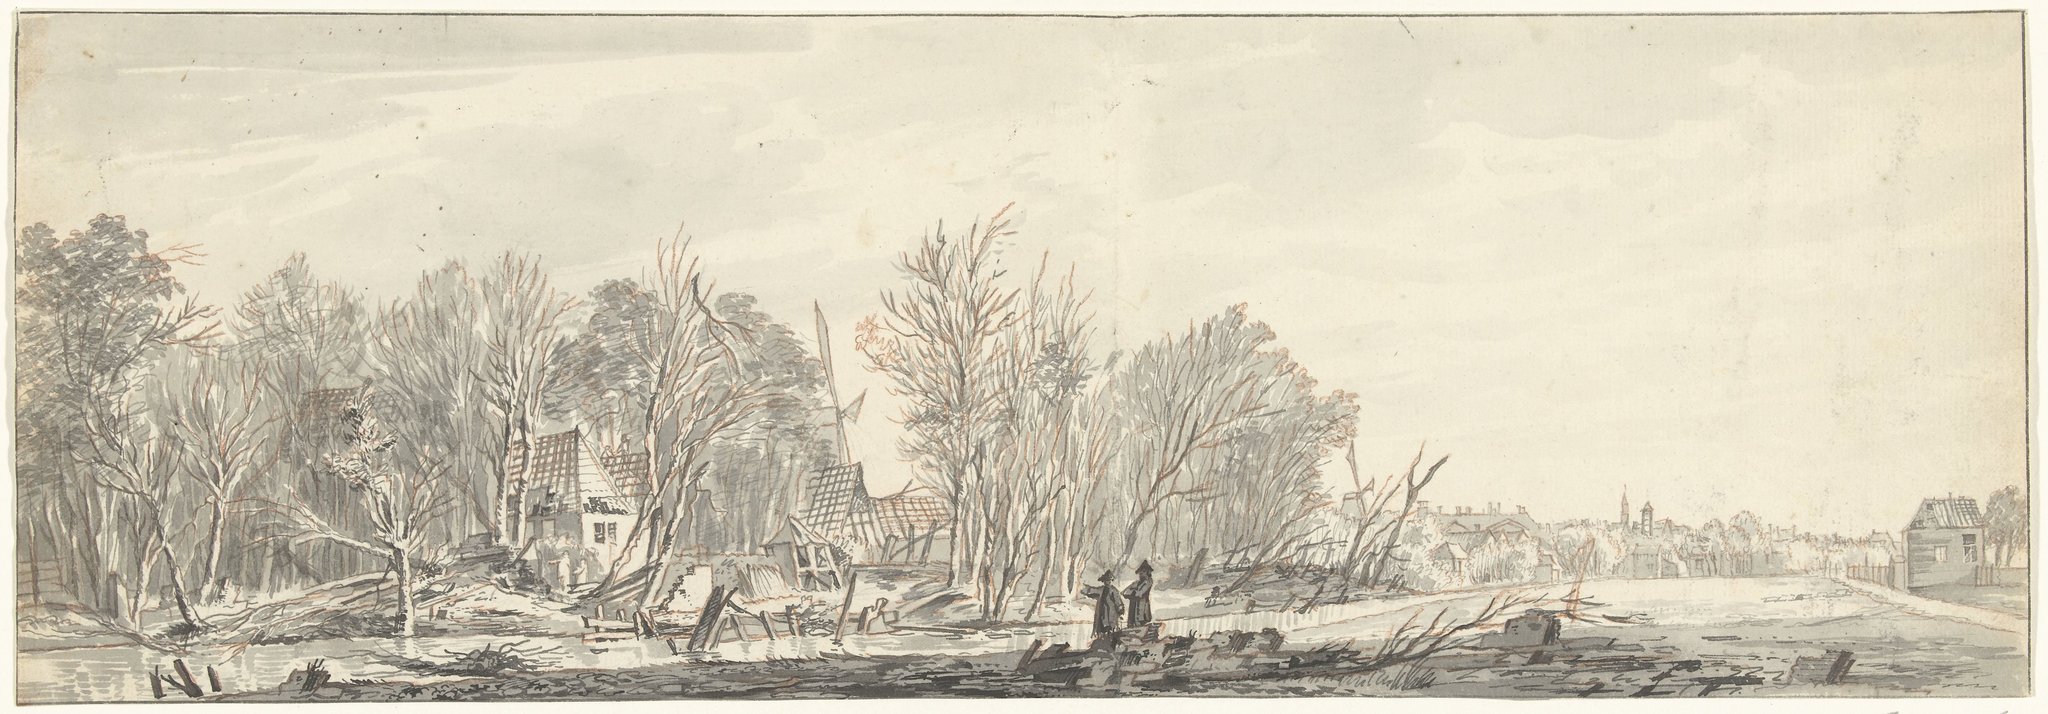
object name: drawing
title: Ruïne van de kruitfabriek Sollenburg na de ontploffing op 14 augustus 1758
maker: Anonymous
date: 1758-1799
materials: paper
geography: northern netherlands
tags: gunpowder disaster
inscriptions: collector's mark: Lugt 2228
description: Niet in Frederik Muller; door het RPK toegevoegd nummer. In het inventarisboek vermeld als door Paulus van Liender, tegenwoordig beschouwd als een anonieme kopie naar de prent van Paulus van Liender uit 1758 (FMH 4085a).